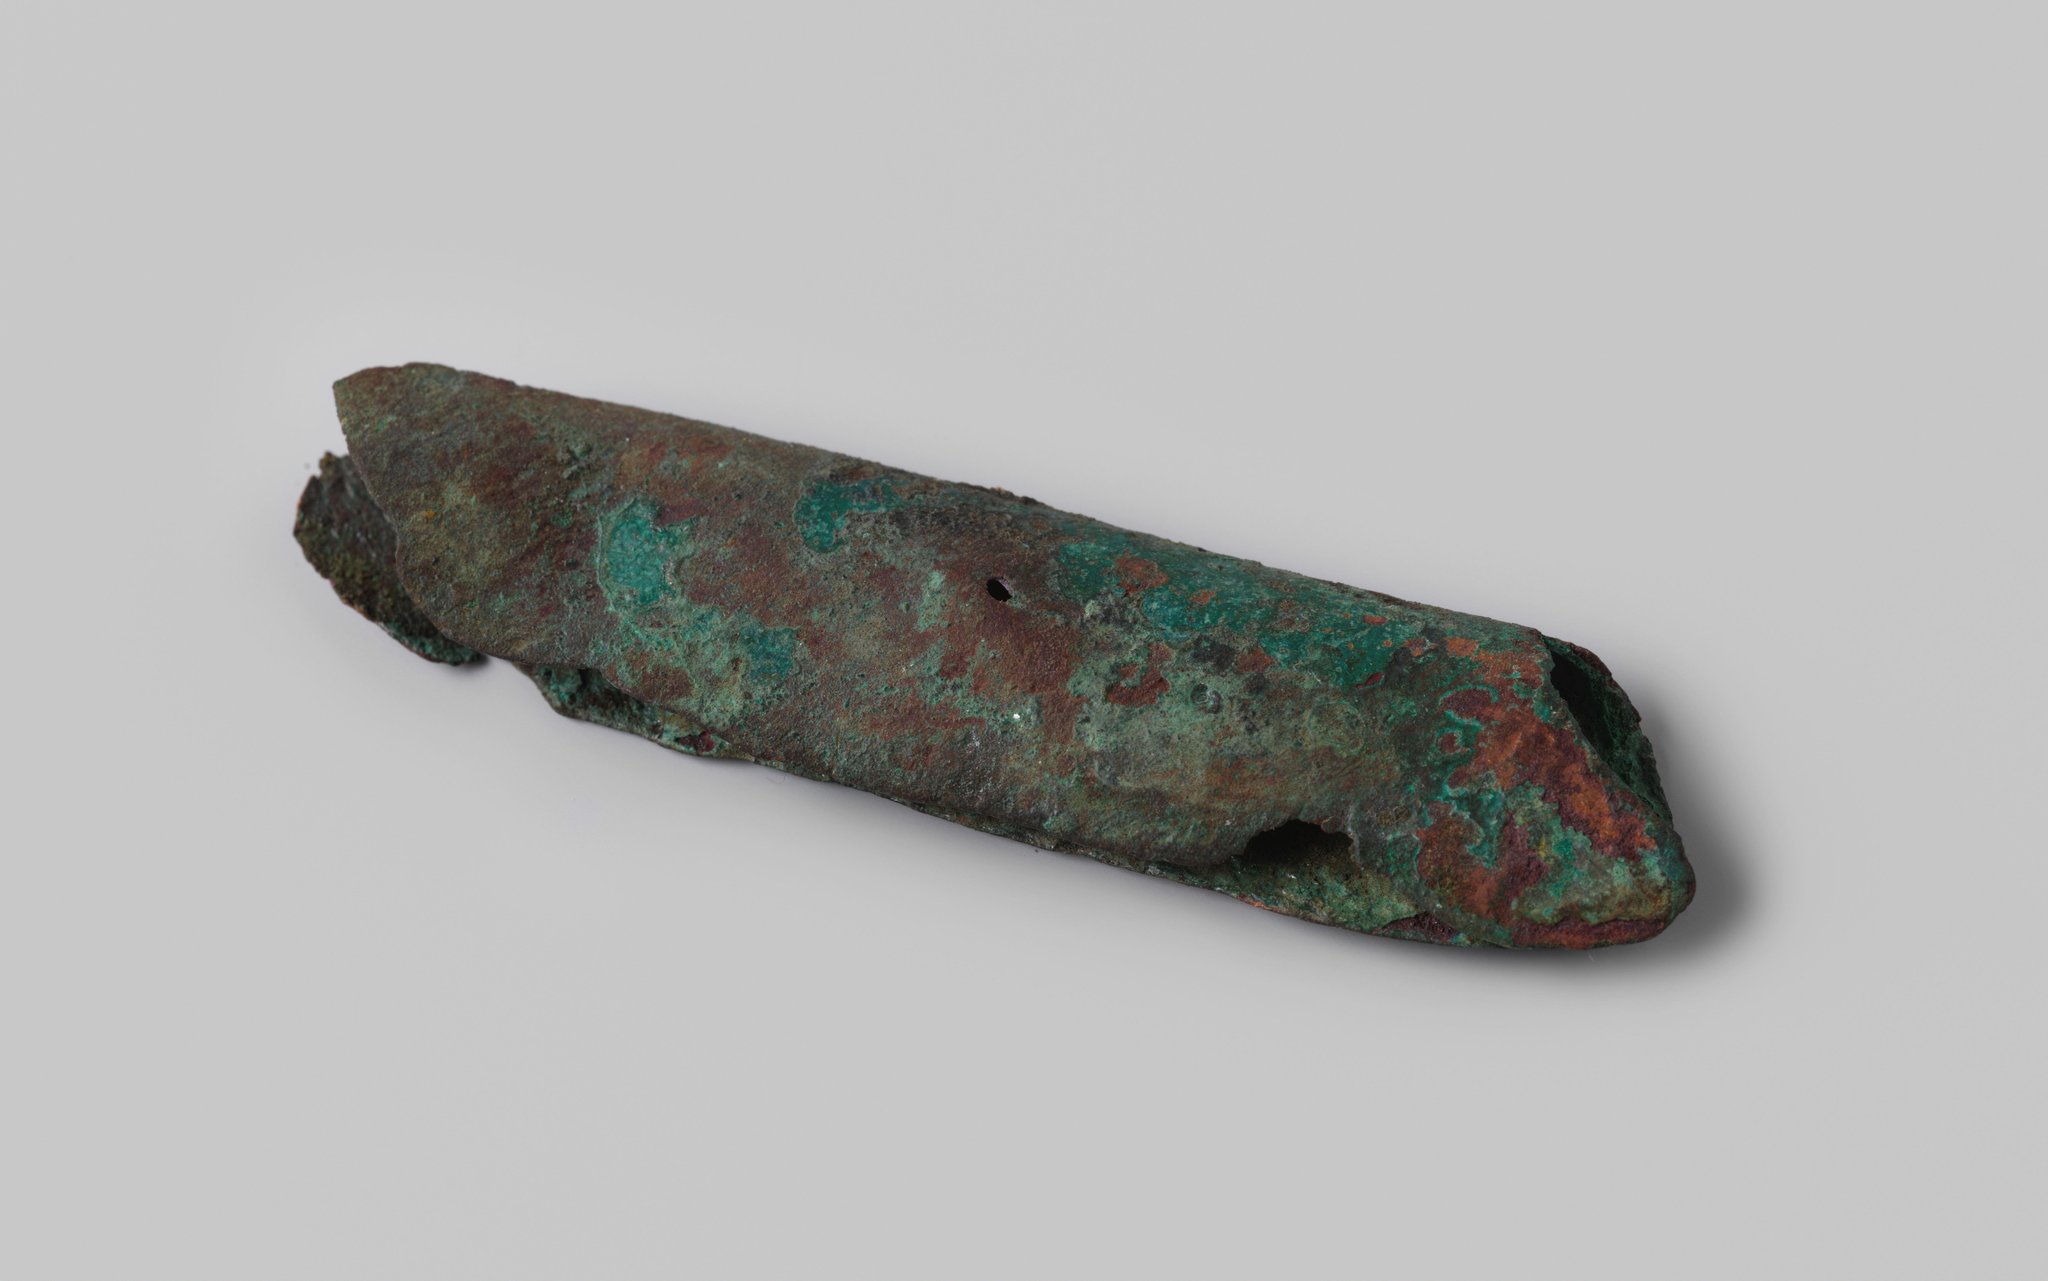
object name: fragment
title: Fragment van koper uit het wrak van de Oost-Indiëvaarder Hollandia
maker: Anonymous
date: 1700-1743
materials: copper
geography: netherlands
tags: verenigde oostindische compagnie, hollandia (schip), annet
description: Varied parts or fragments, strips and strip-shaped fragments; fragm.